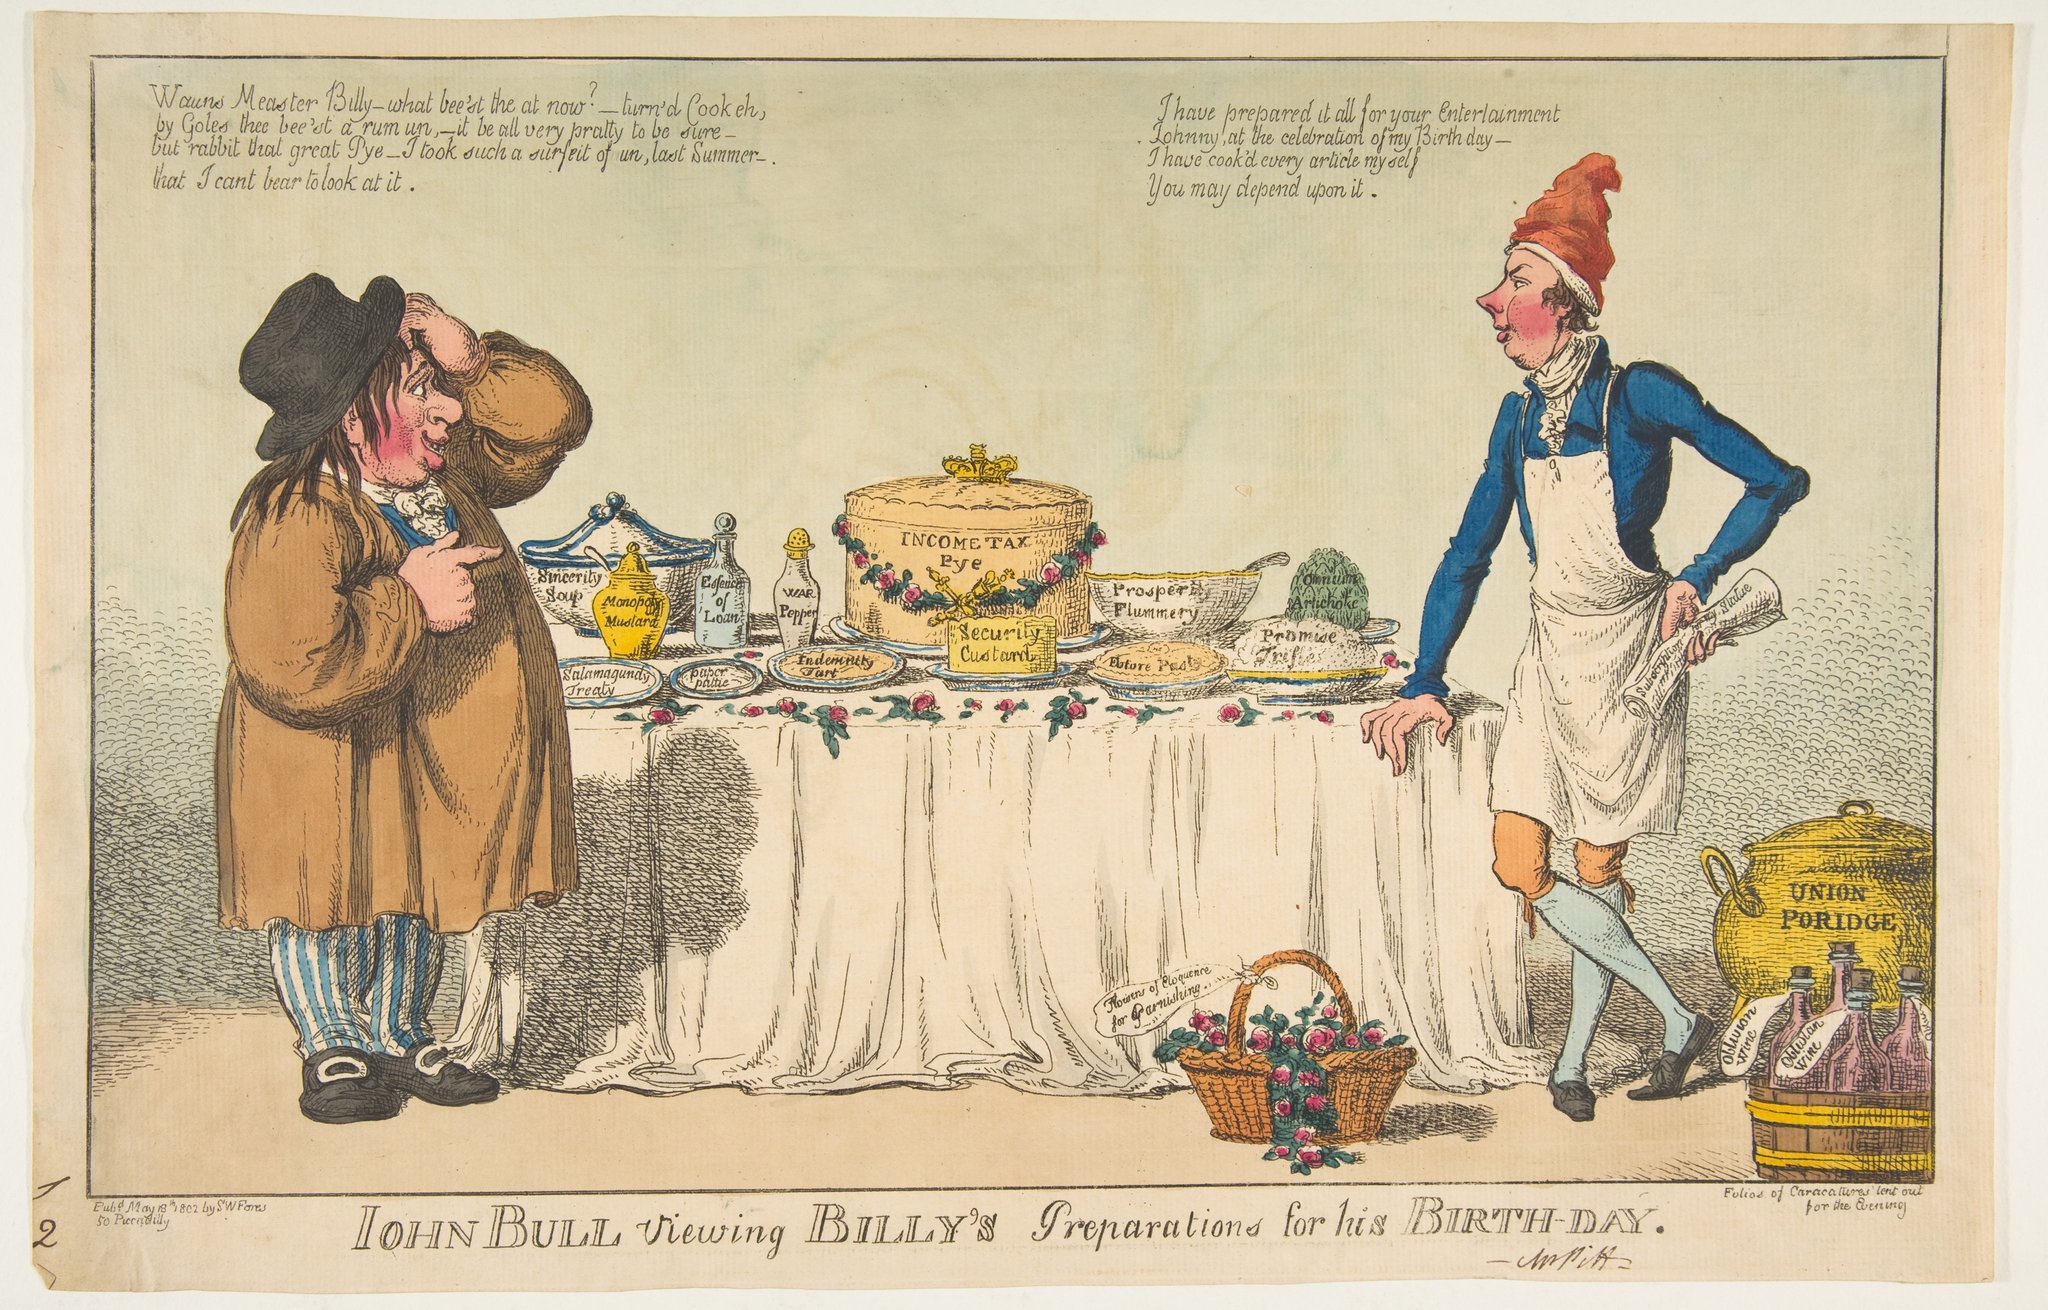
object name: print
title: John Bull Viewing Billy's Preparations for his Birth-day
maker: charles williams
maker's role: artist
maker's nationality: british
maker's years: 1750-1850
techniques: etching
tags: food,satire,men,politics